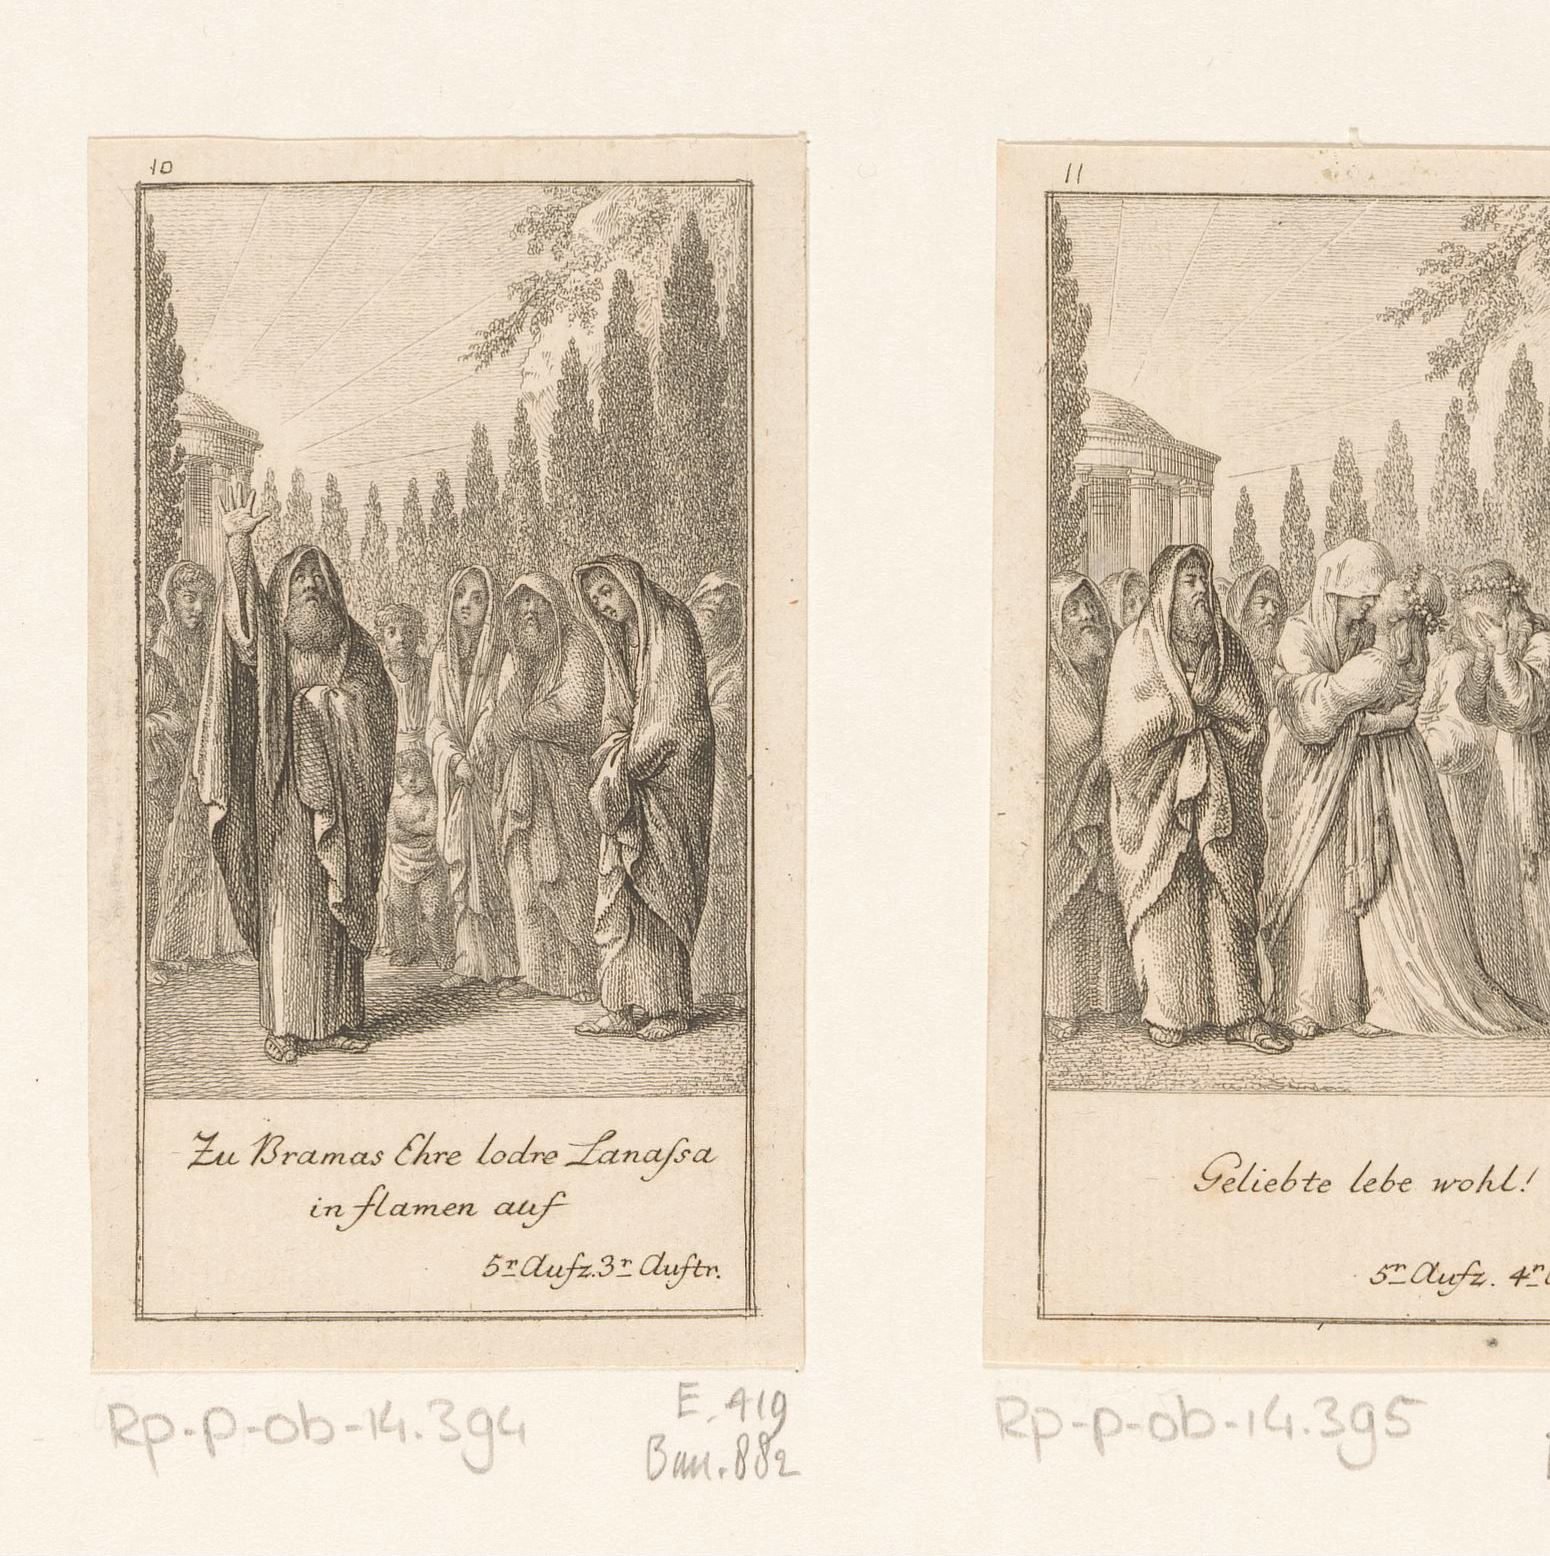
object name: book illustration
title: Oude brahmaan begint het offerritueel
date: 1782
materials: paper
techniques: etching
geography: lauenburg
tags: human sacrifice ~ non-christian religions, trees: cypress, literature, priest ~ non-christian religions, temple, shrine ~ non-christian religions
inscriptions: collector's mark: Lugt 2228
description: Vervaardigd voor Karl Martin Plümicke's 'Lanassa'. Prent gebruikt voor: Köningl. Grosbr. Genealogischer Kalender auf das 1783 Jahr. Lauenburg: J. G. Berenberg, 1782.